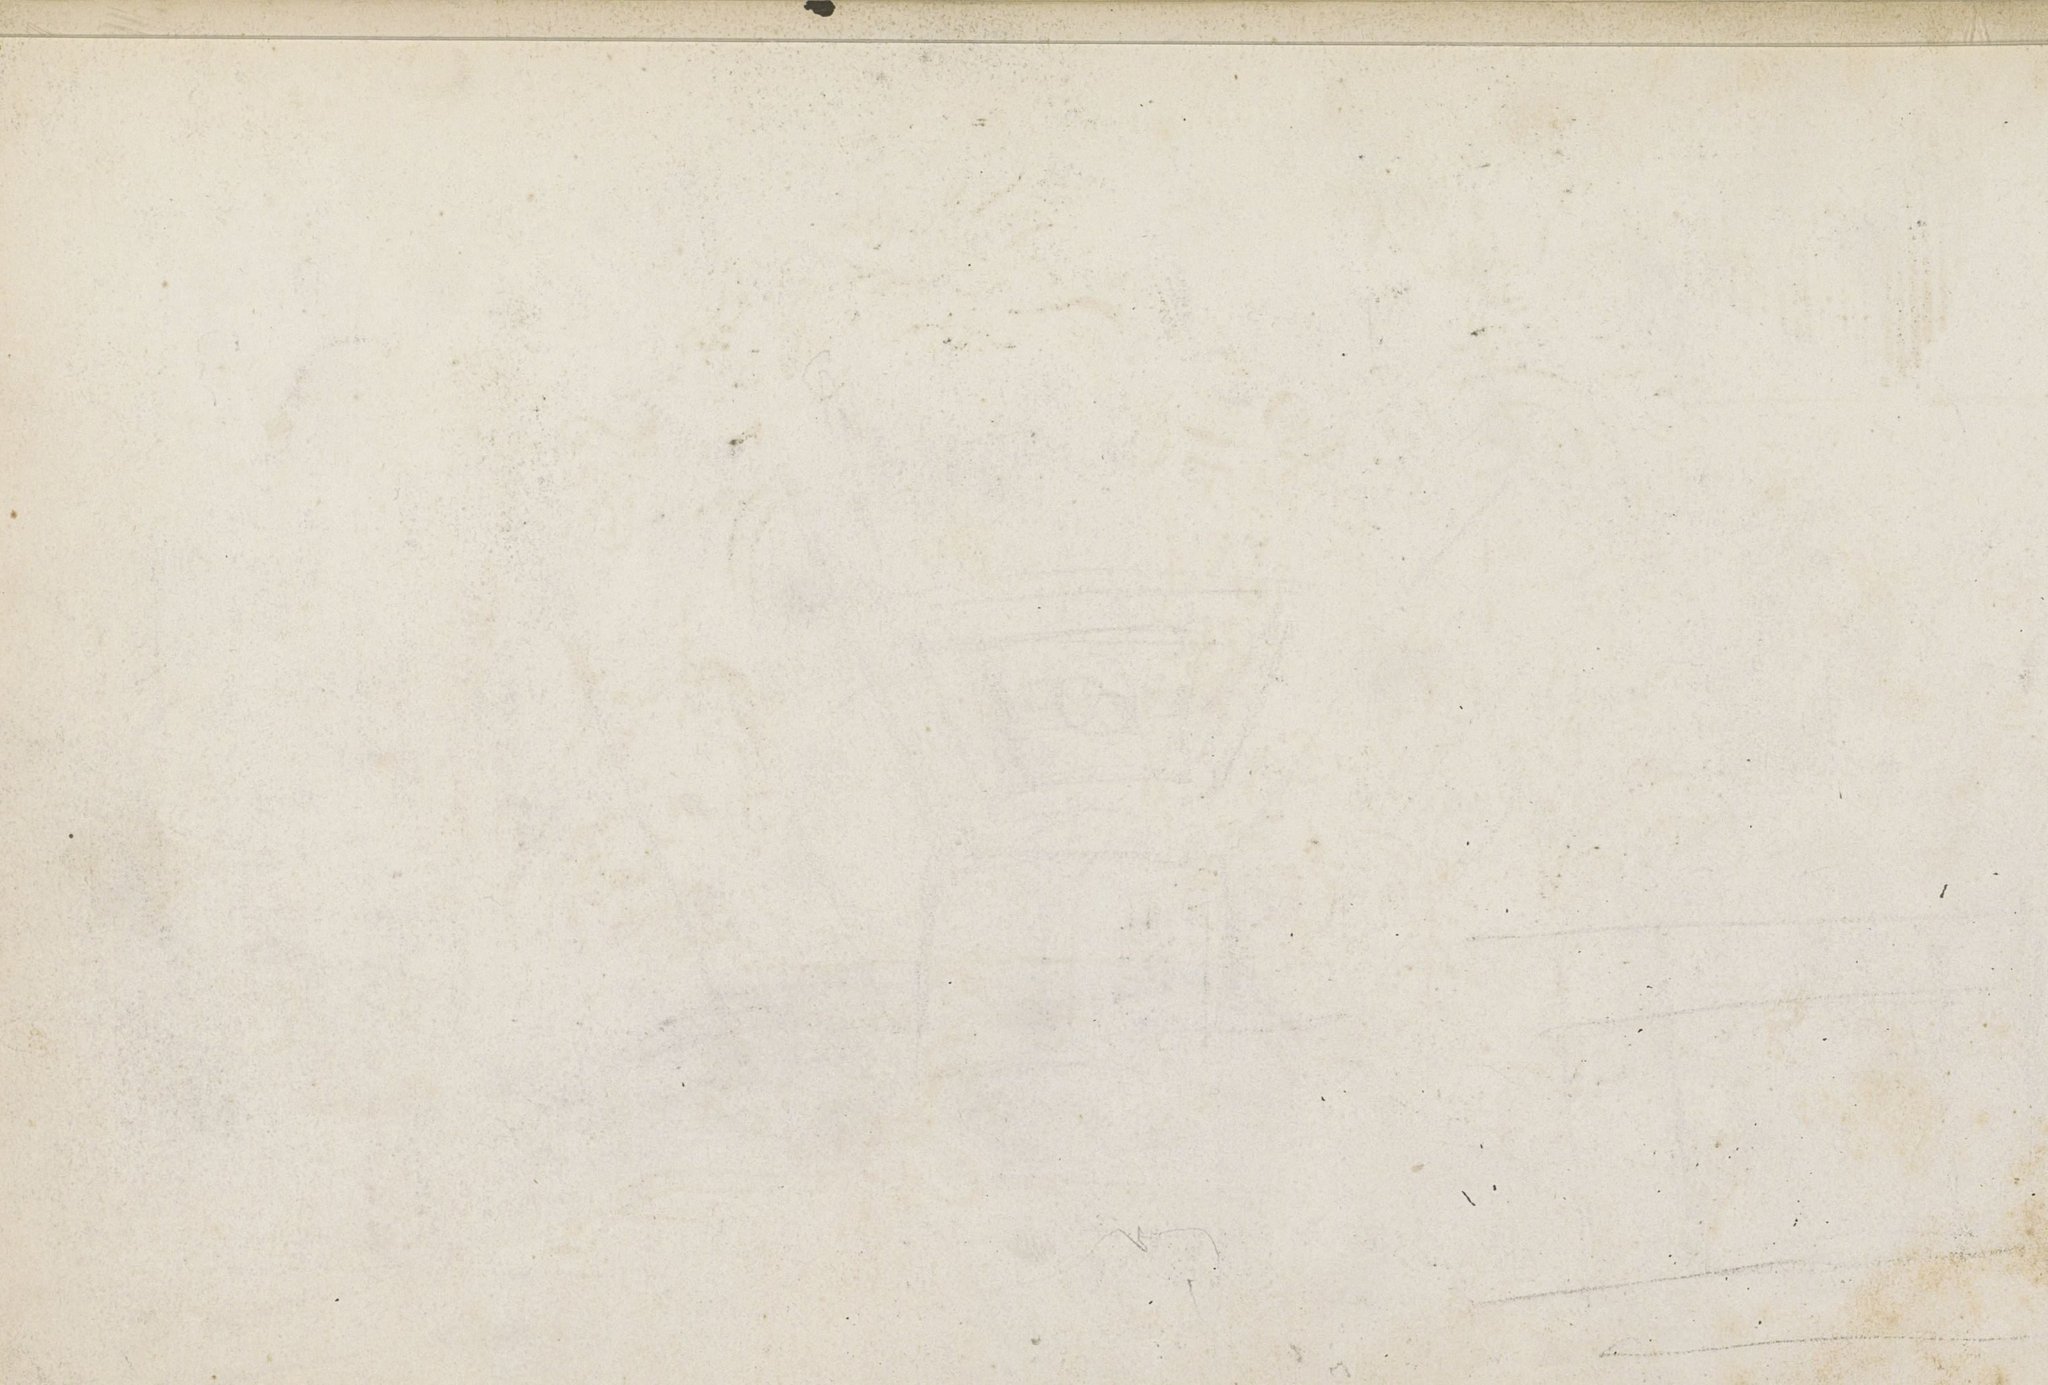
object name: sketchbook leaf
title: Studie, mogelijk een kelk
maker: isaac gosschalk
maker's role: draughtsman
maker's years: 1838-1907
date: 1862-1867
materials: paper, pencil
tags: chalice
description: Blad 8 verso uit een schetsboek met 58 bladen.